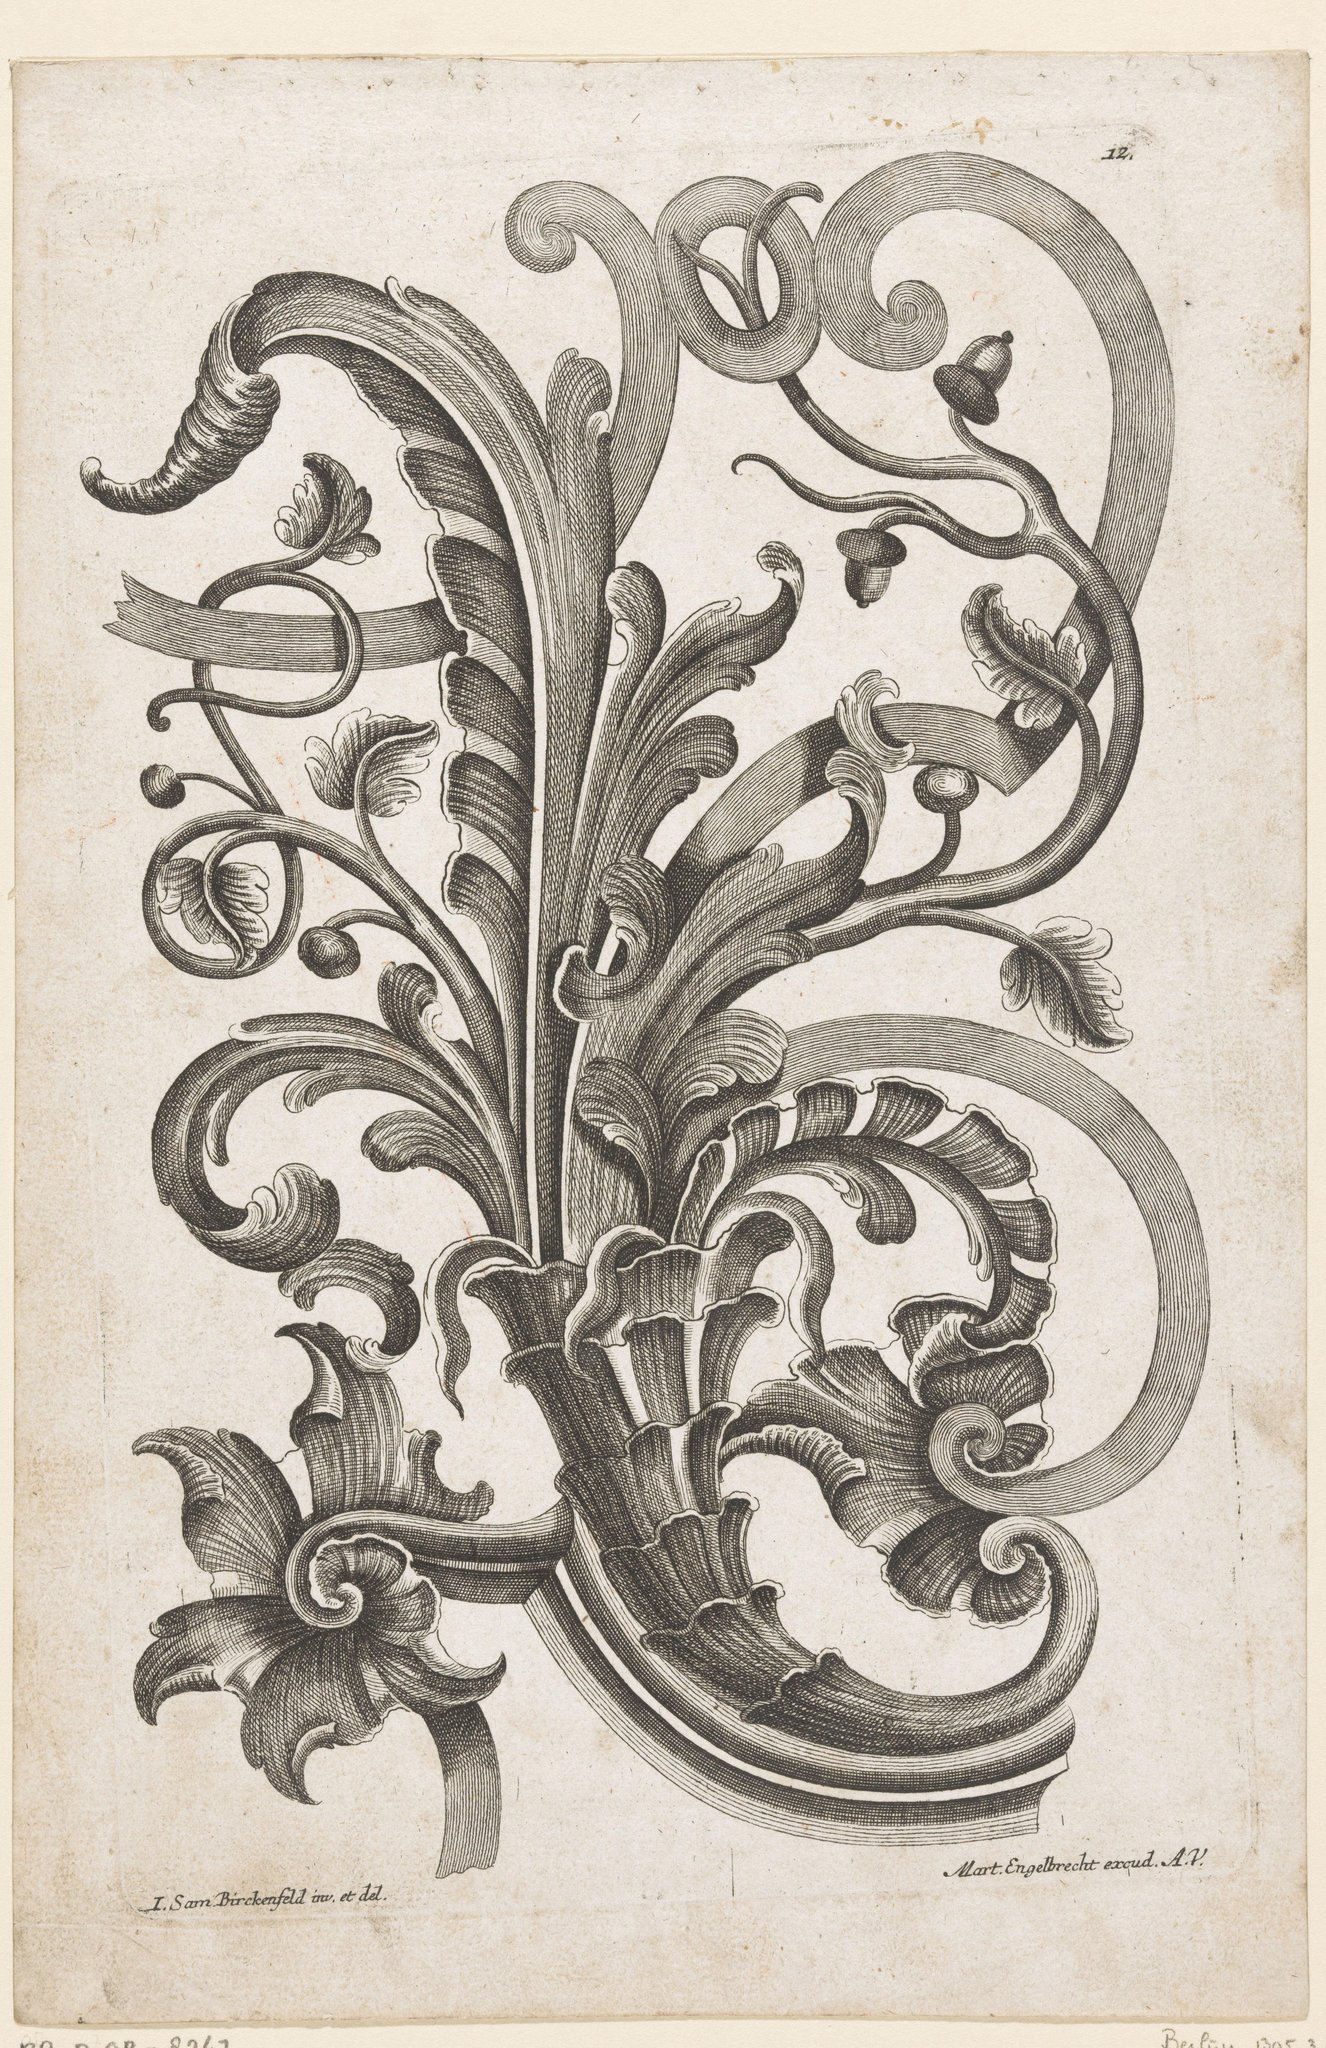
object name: print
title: Ontwerpen voor smeedwerk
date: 1694-1756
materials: paper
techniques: etching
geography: augsburg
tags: floral interlace ~ ornament, forging (industrial process) (+ product ~ crafts, industries, agriculture)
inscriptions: collector's mark: Lugt 2228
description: De prent hoort bij een serie van vier prenten.